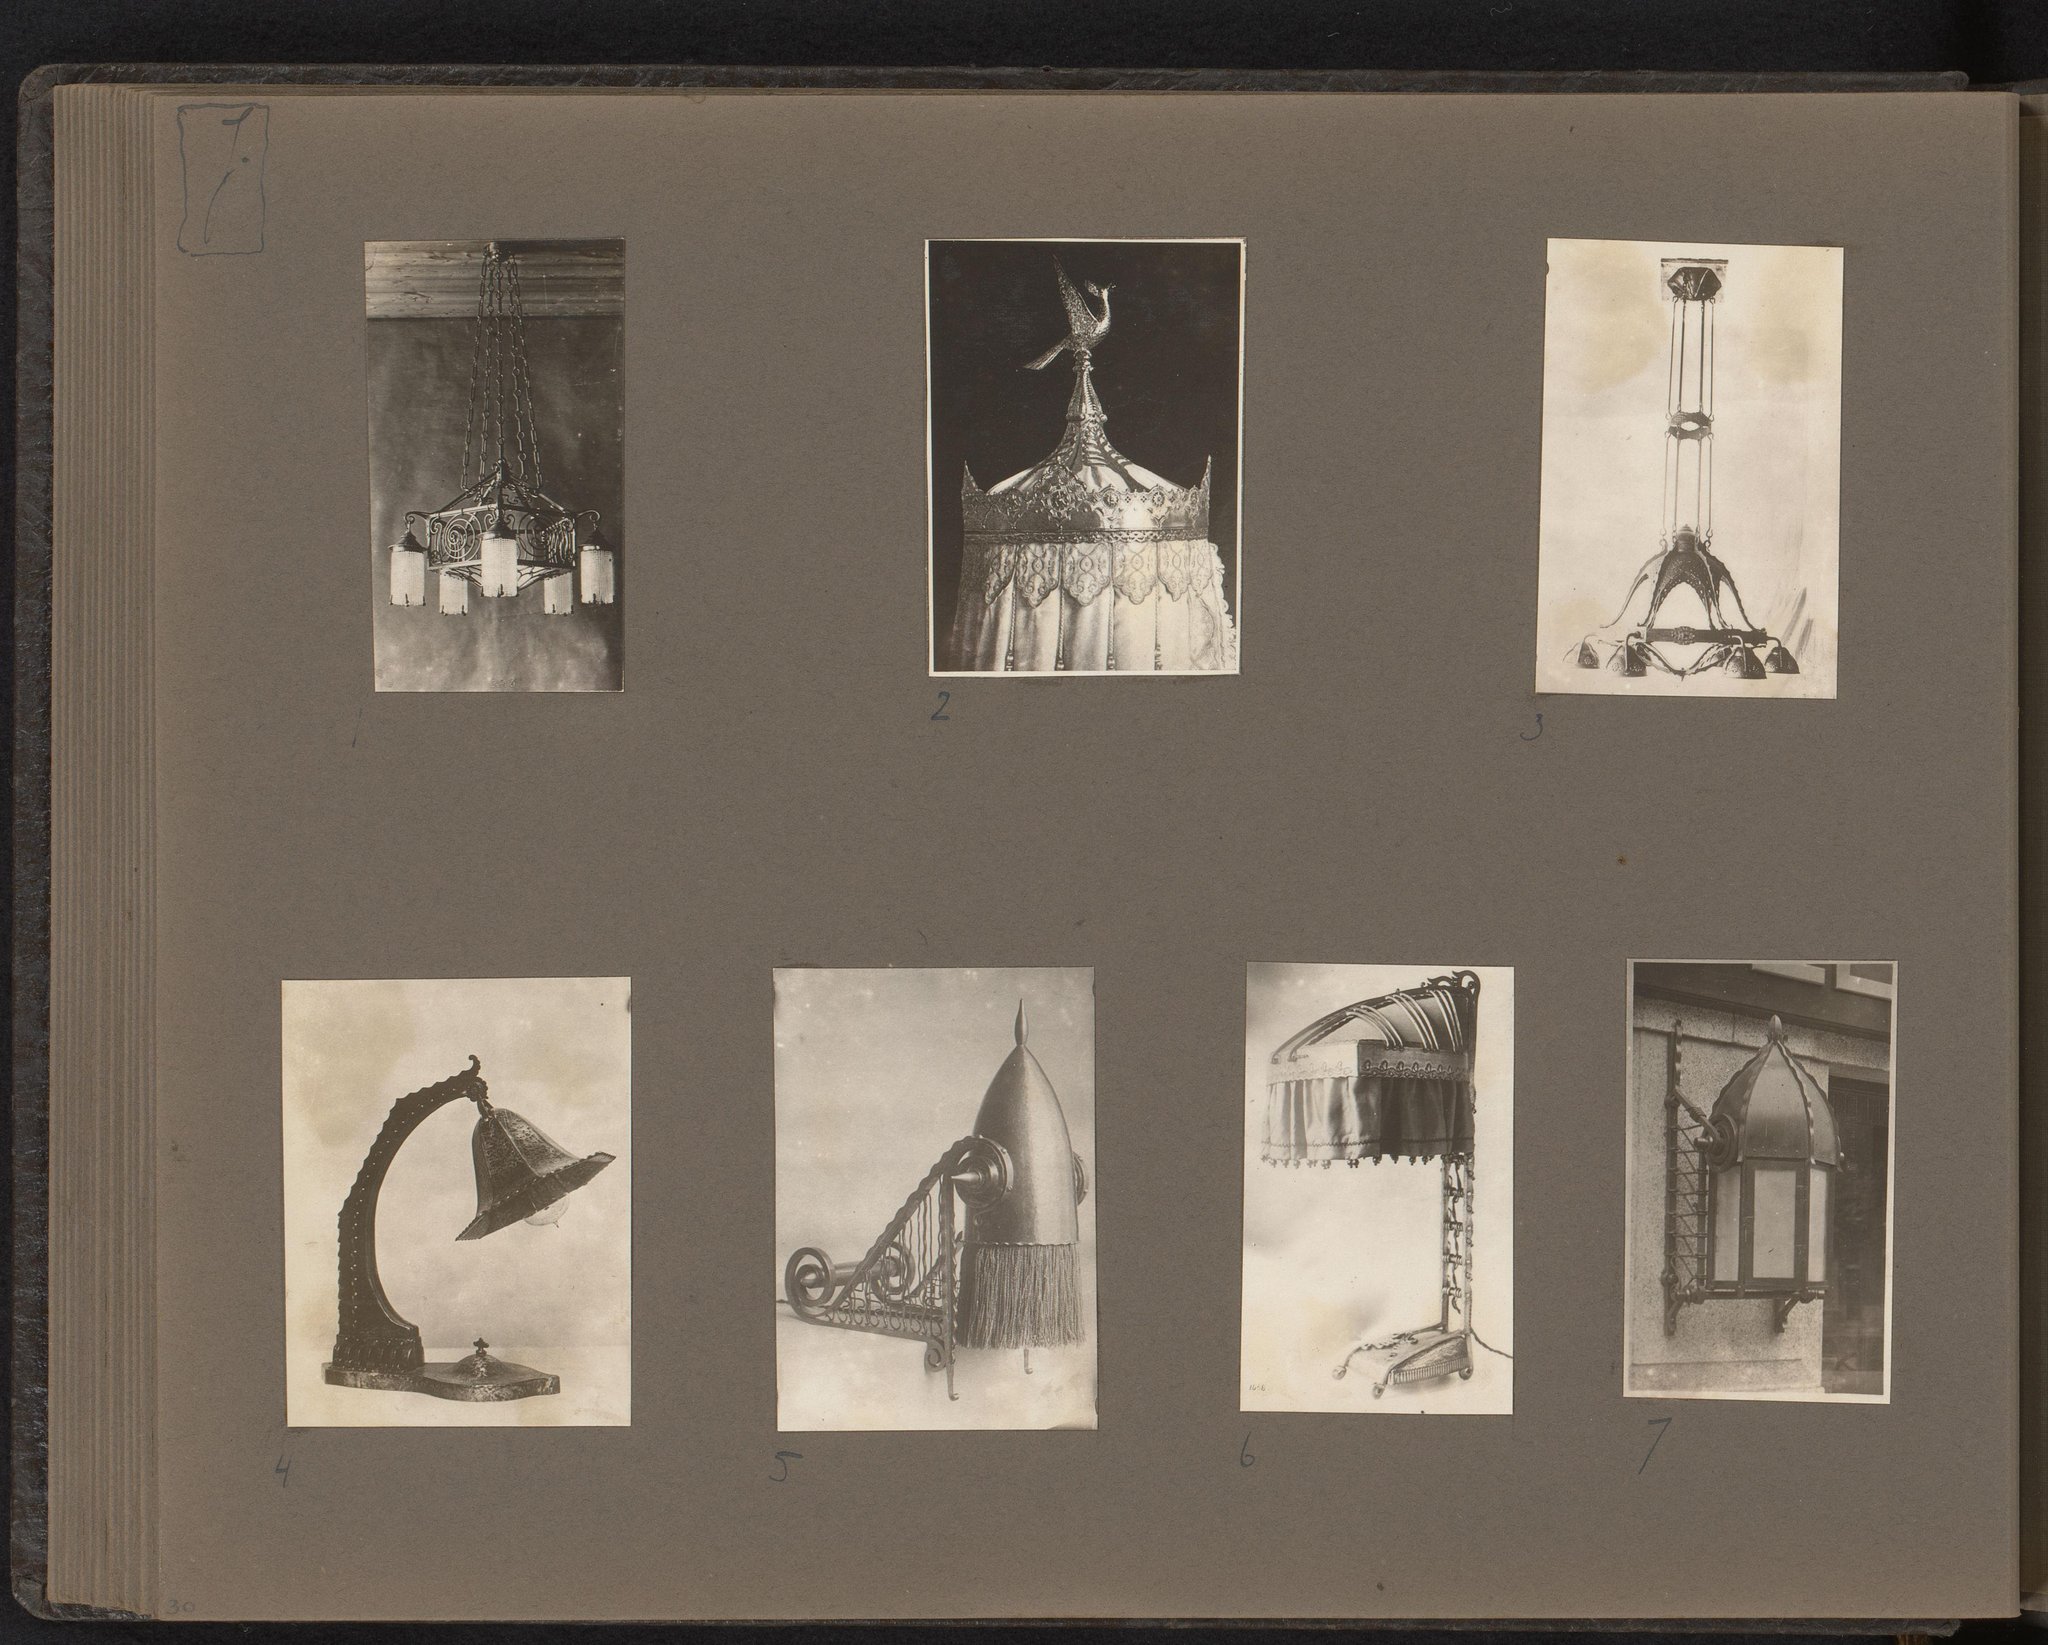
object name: photograph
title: Zeven lampen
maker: Anonymous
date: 1920-1940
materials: paper, photographic support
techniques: gelatin silver print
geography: netherlands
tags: lighting; lamps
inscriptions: number: ‘1 - 2 - 3/ 4 - 5 - 6 - 7’, annotation: ‘J.’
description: Zeven foto's van lampen, waarvan twee van hanglampen, een van een lantaarn en drie van staande lampen. Deze foto's maken deel uit van een album.